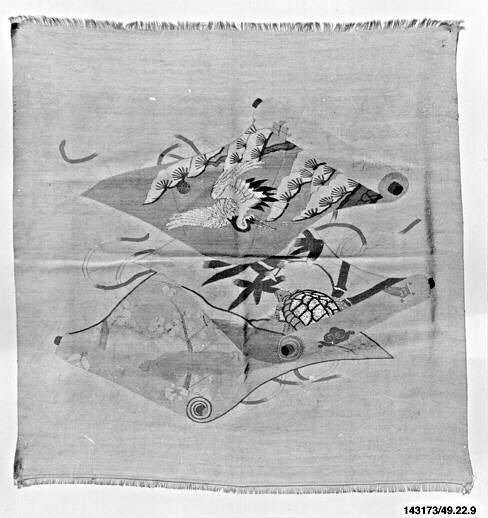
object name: gift cloth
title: Gift Cloth (Fukusa)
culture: japanese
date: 1801-1900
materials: metal thread, silk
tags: cranes,turtles